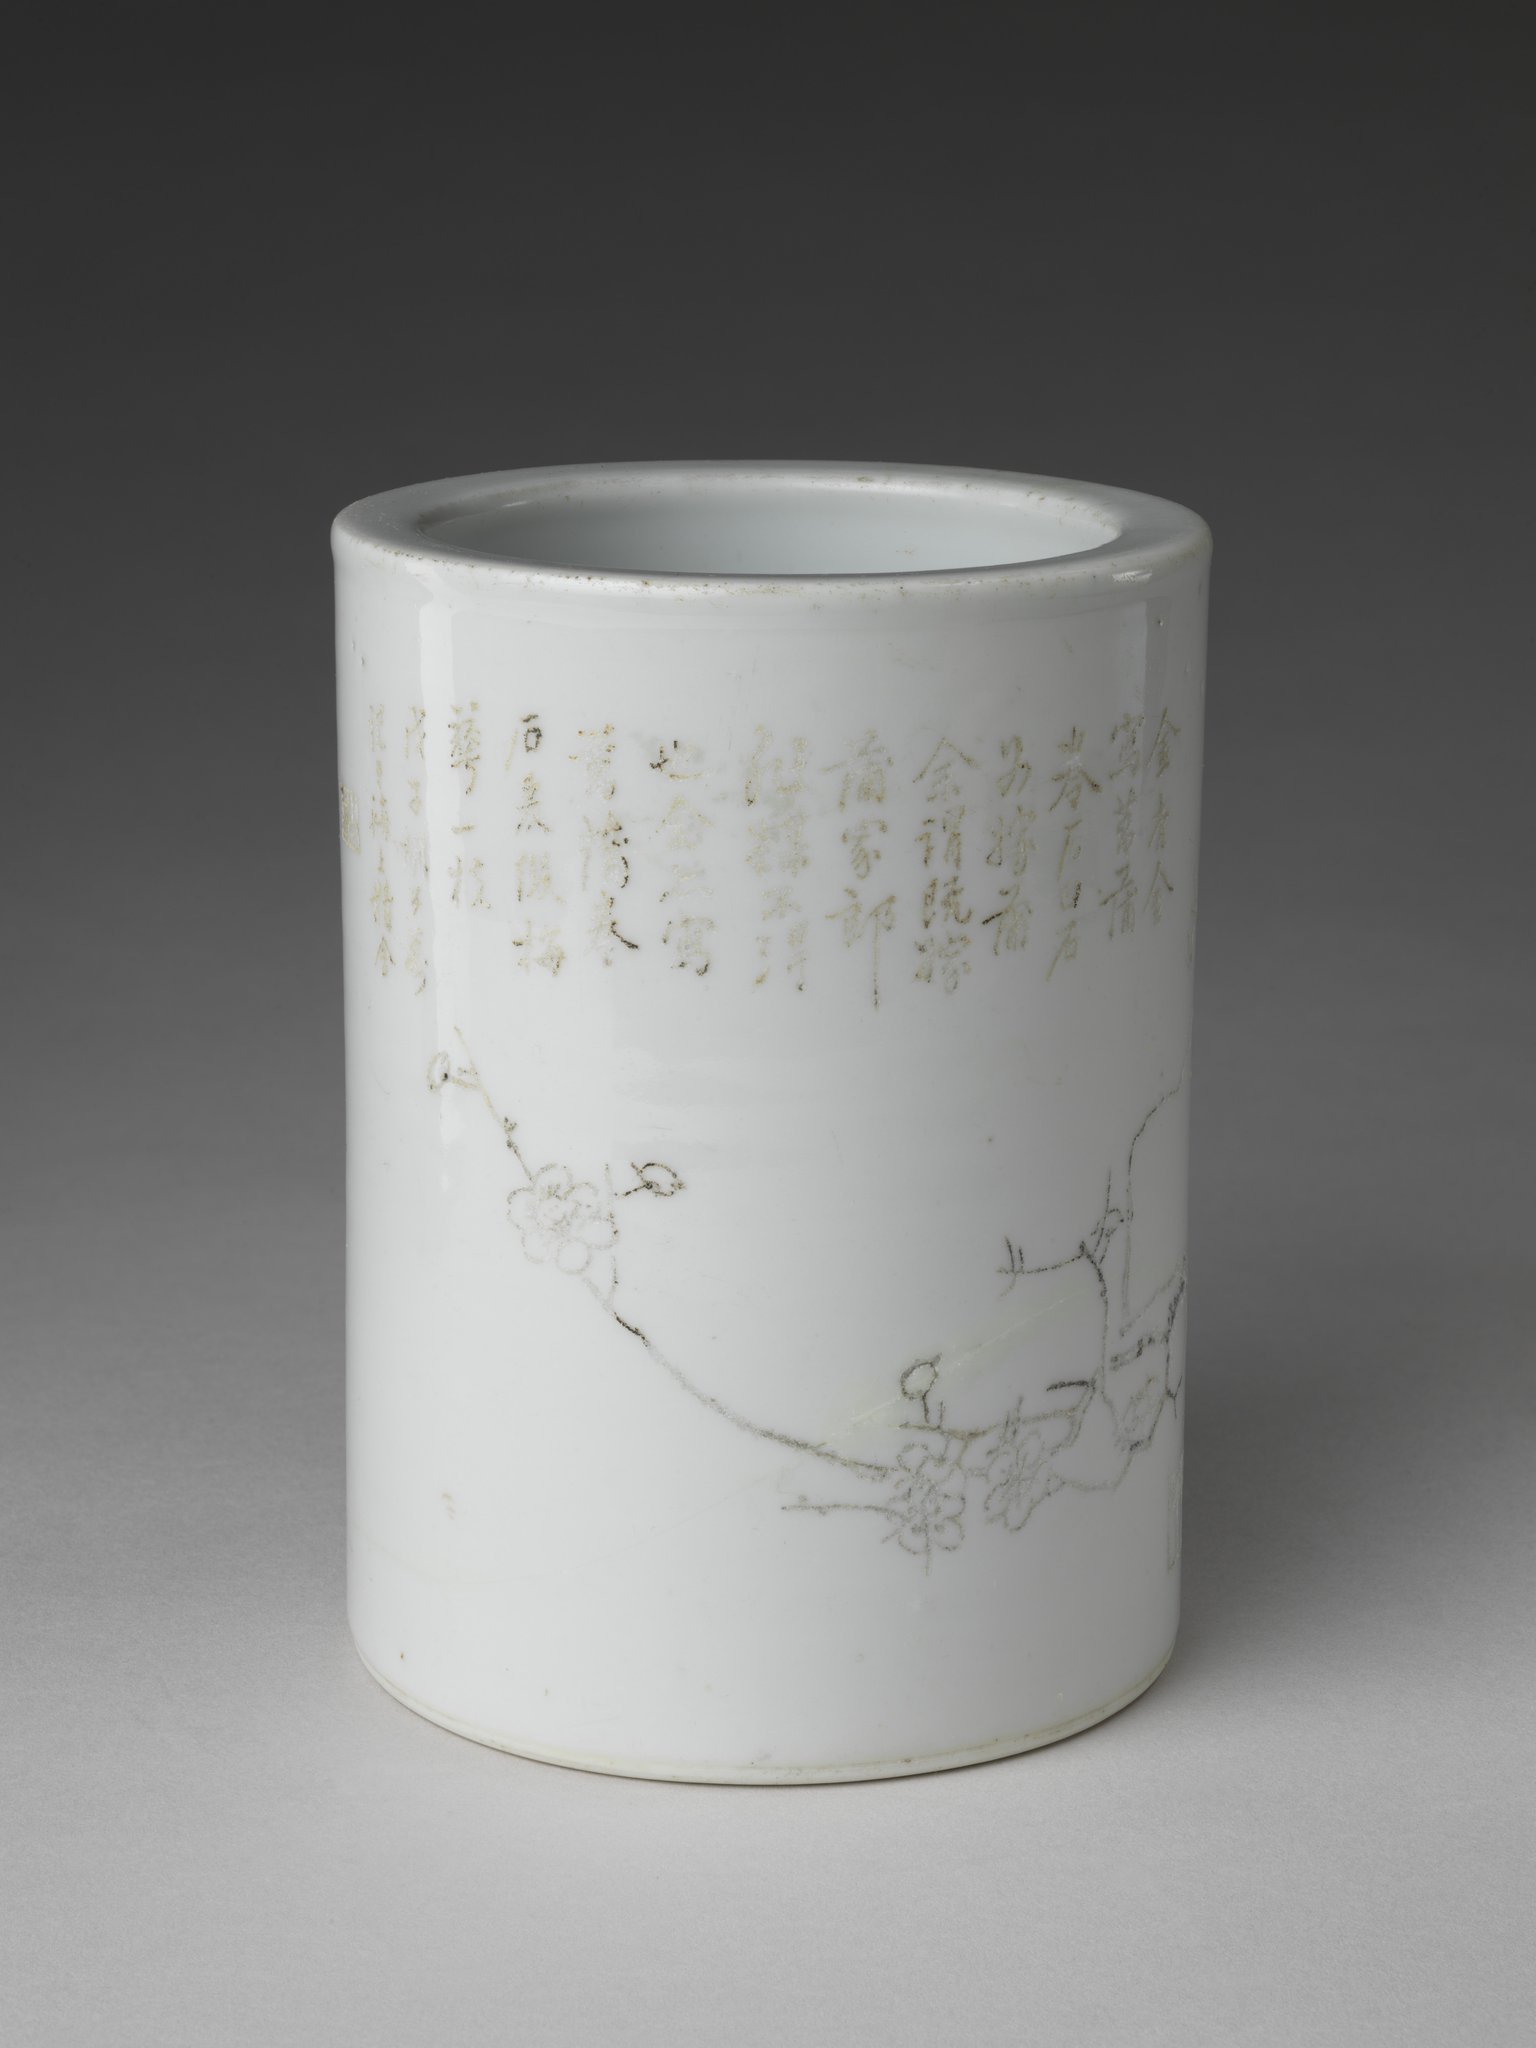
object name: brush holder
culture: chinese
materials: glaze, ink, porcelain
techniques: painting